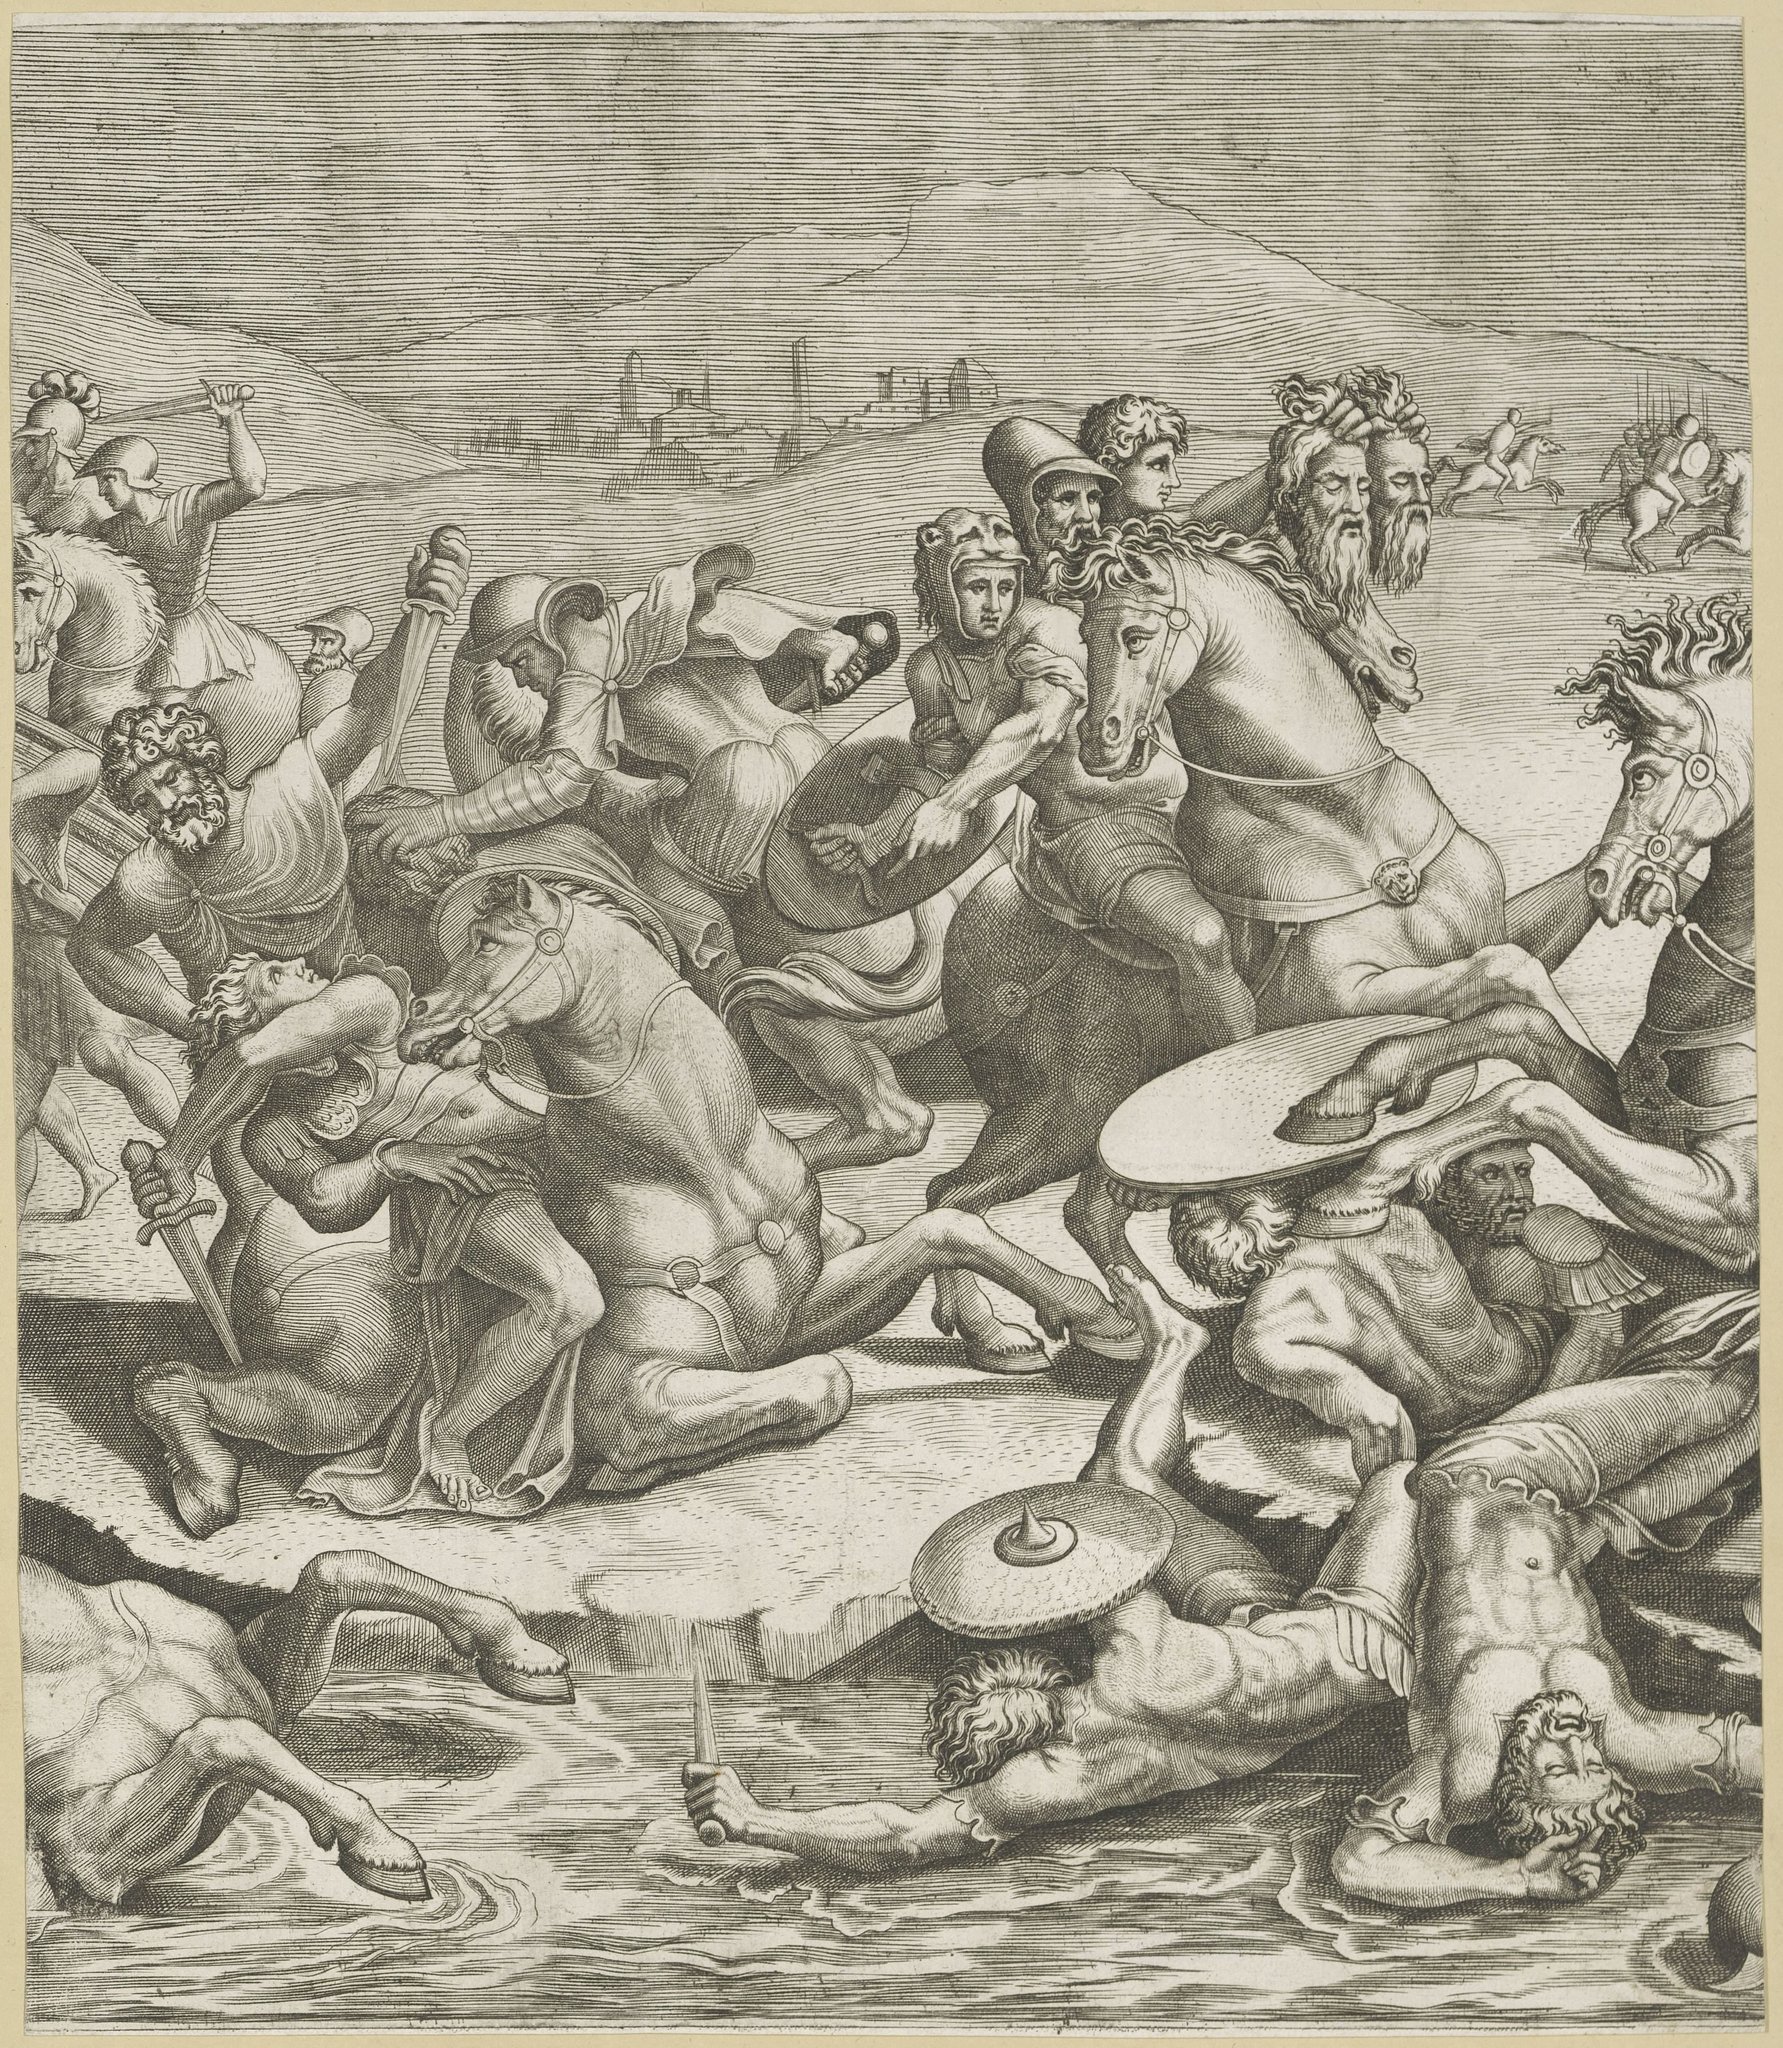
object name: print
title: Slag bij de Milvische brug (linker middenblad)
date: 1500-1599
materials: paper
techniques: engraving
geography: italy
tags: the battle of the milvian bridge (saxa rubra): st. constantine on horseback confronts maxentius; a cross appears in the sky with in fiery letters 'in hoc signo vinces' (the raised standards of the roman soldiers carry a cross or the chi-rho monogram), warfare; military affairs (+ cavalry, horsemen), the soldier; the soldier's life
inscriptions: collector's mark: Lugt 11, collector's mark: Lugt 10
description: Gevechtsscène in een landschap: slag bij de Milvische brug. De soldaten van Constantijn in gevecht met de soldaten van Maxentius. Dode lichamen liggen op de grond. Soldaten te paard verdrinken in de rivier.